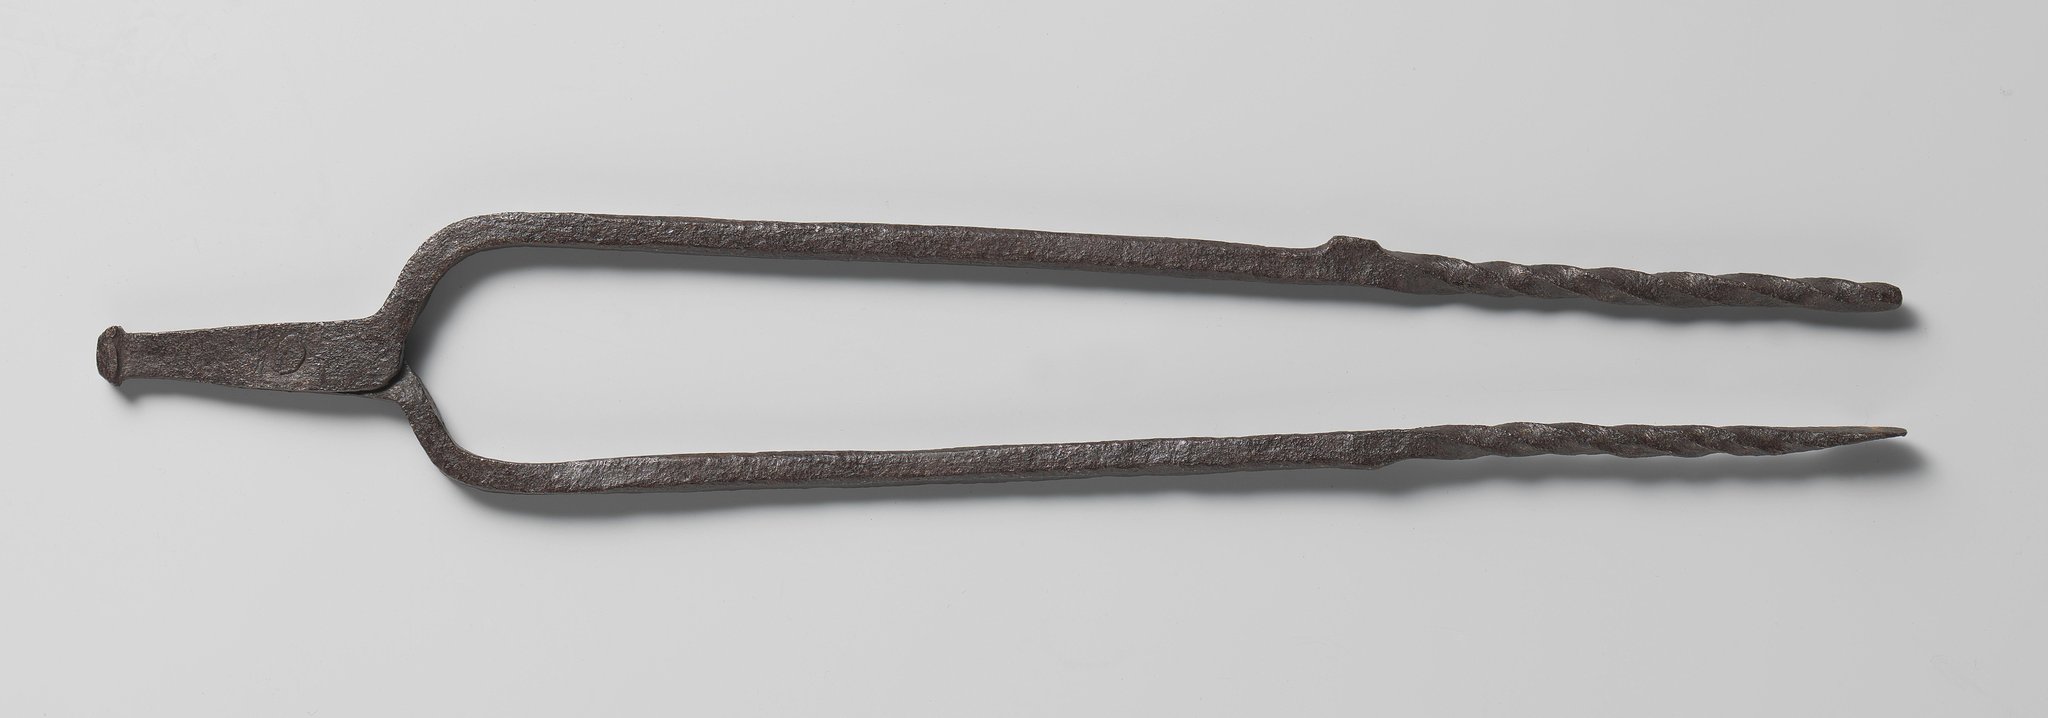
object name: tang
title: Andiron with cooking pots and a pair of fire tongs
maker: Anonymous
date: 1590-1596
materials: iron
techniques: forging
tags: willem barendsz., amsterdam, jacob van heemskerck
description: Centrally located in the ‘Safe House’ was a fireplace with a chimney above it. The food was cooked there and the men could warm themselves by the open hearth. When the ‘Safe House’ was rediscovered at the end of the 19th century, the andiron and the cooking pots were still in place.